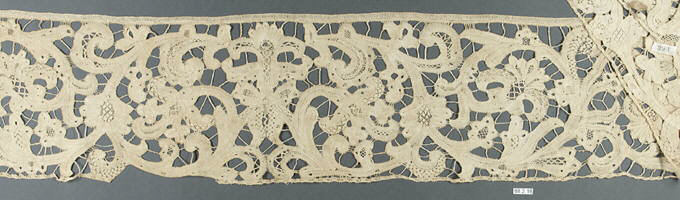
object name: fragment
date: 1601-1700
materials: lace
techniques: lace